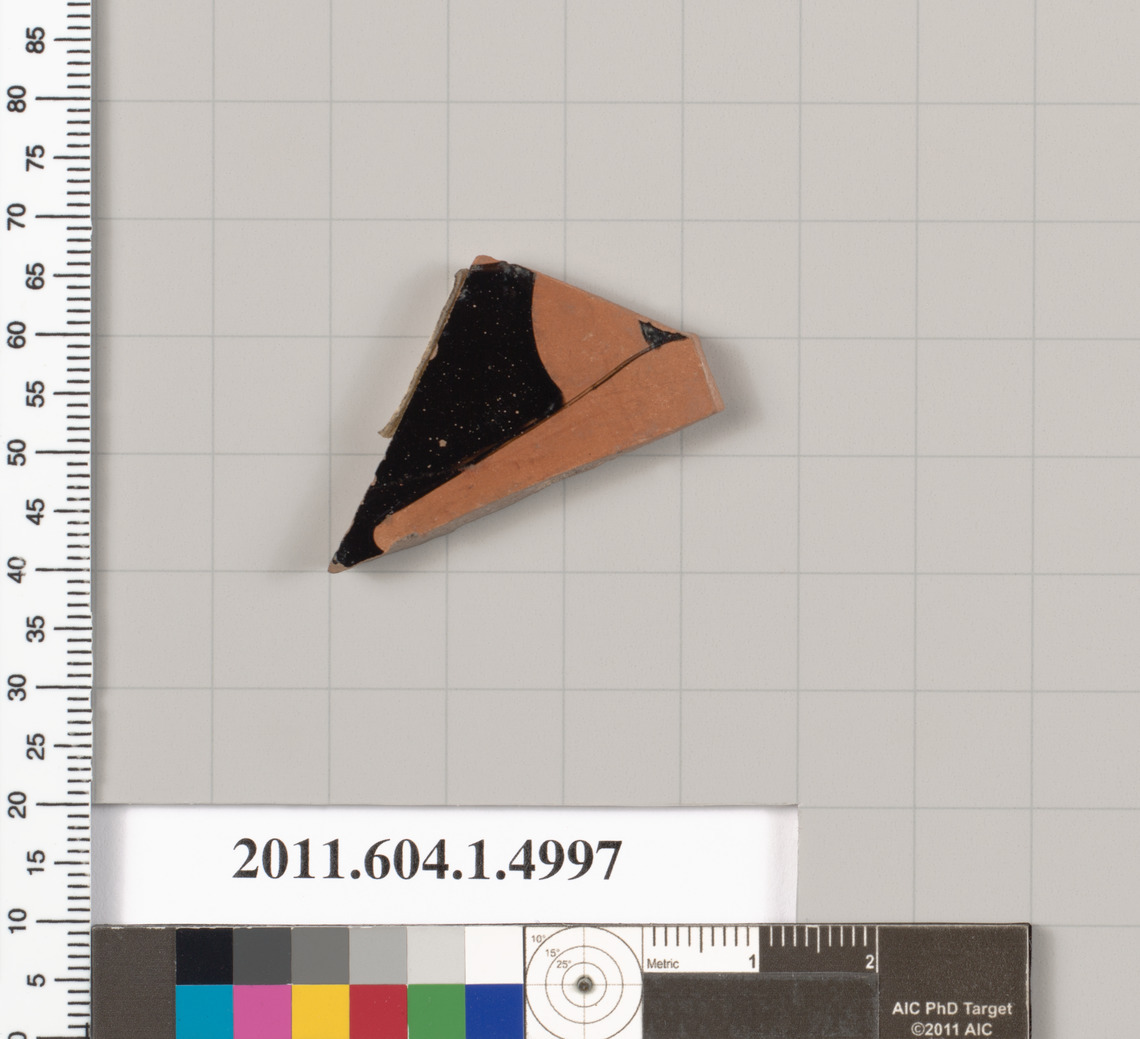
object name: kylix fragment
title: Terracotta fragment of a kylix (drinking cup)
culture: greek, attic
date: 500-480 BCE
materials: terracotta